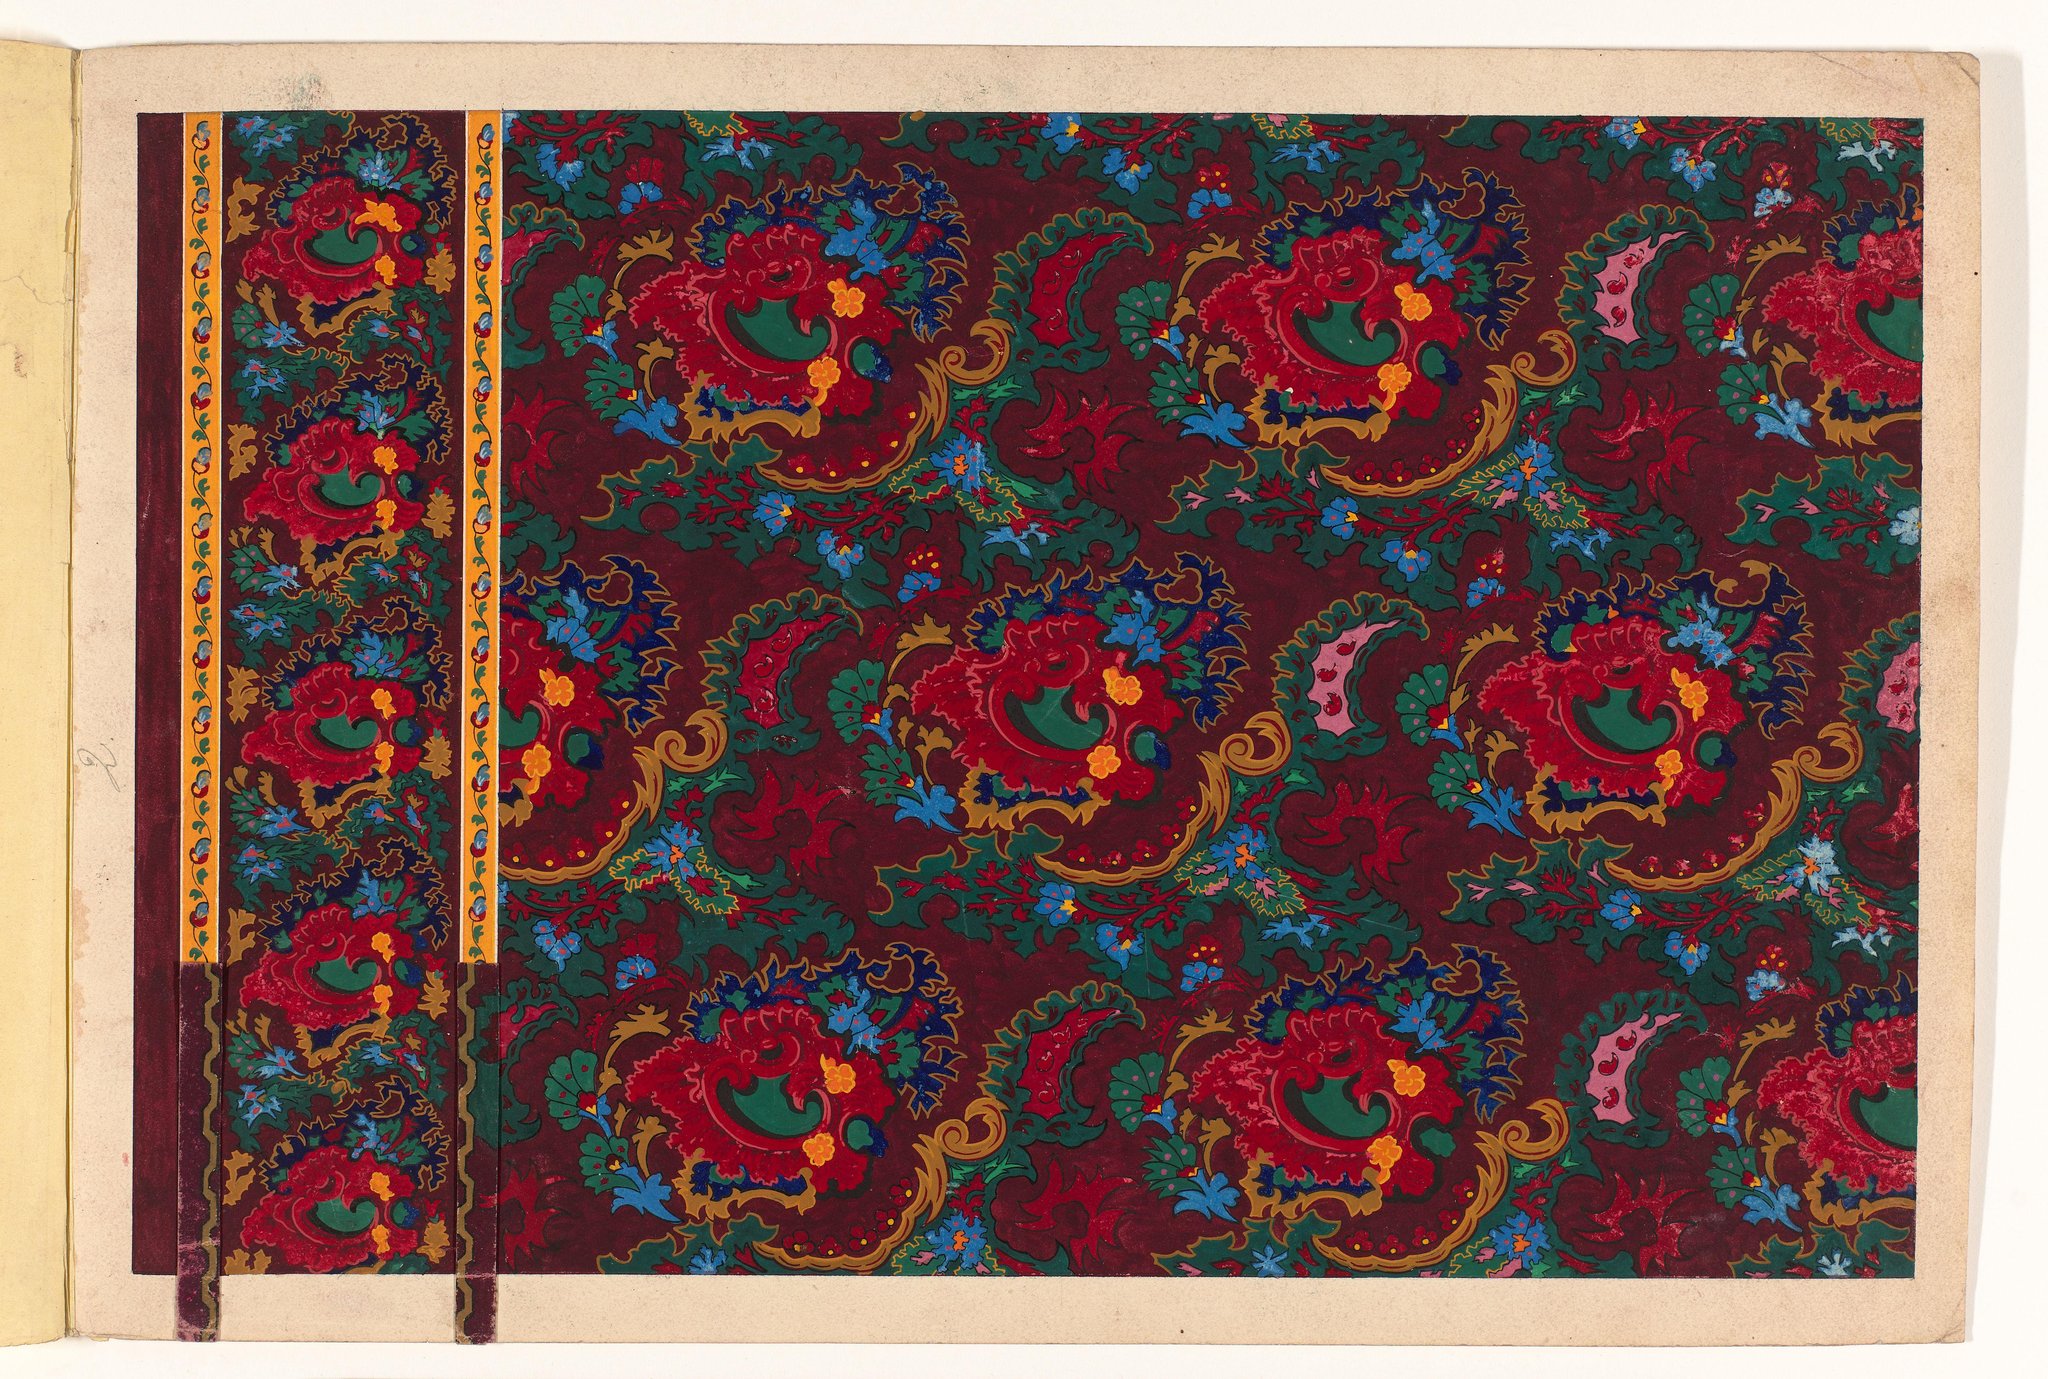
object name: drawing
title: Ontwerp voor een tapijt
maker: Anonymous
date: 1854-1864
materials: gouache, paper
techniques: brush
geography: amsterdam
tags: ornaments ~ art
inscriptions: inscription: ‘[...]D Ekas’, retailer's mark: ‘JHS.’, number: ‘No 398.’, inscription: ‘P Te[...]ngen.’, number: ‘2.’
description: De presentatietekeningen BK-1971-77-1 t/m 86 zijn kopieën van de originele ontwerptekeningen. Ze werden gemaakt voor vertegenwoordigers van bijvoorbeeld magazijnen, die ze aan hun klanten konden tonen. De meeste tekeningen tonen een kwart van het dessin inclusief rand, middenpartij (de zogenaamde grond of fond) en centraal medaillon. Door het gebruik van spiegels kan de illusie van het gehele tapijt worden opgeroepen. Een deel van de tekeningen heeft een alfabetische opeenvolgende letter als kenmerk, de andere groep een cijfer.Waarschijnlijk is de reeks dessins met een letter eerder samengesteld dan de genummerde tekeningen.